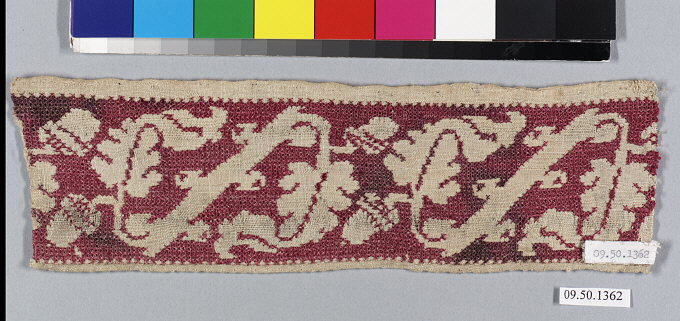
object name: border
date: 1501-1700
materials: linen, silk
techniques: embroidery